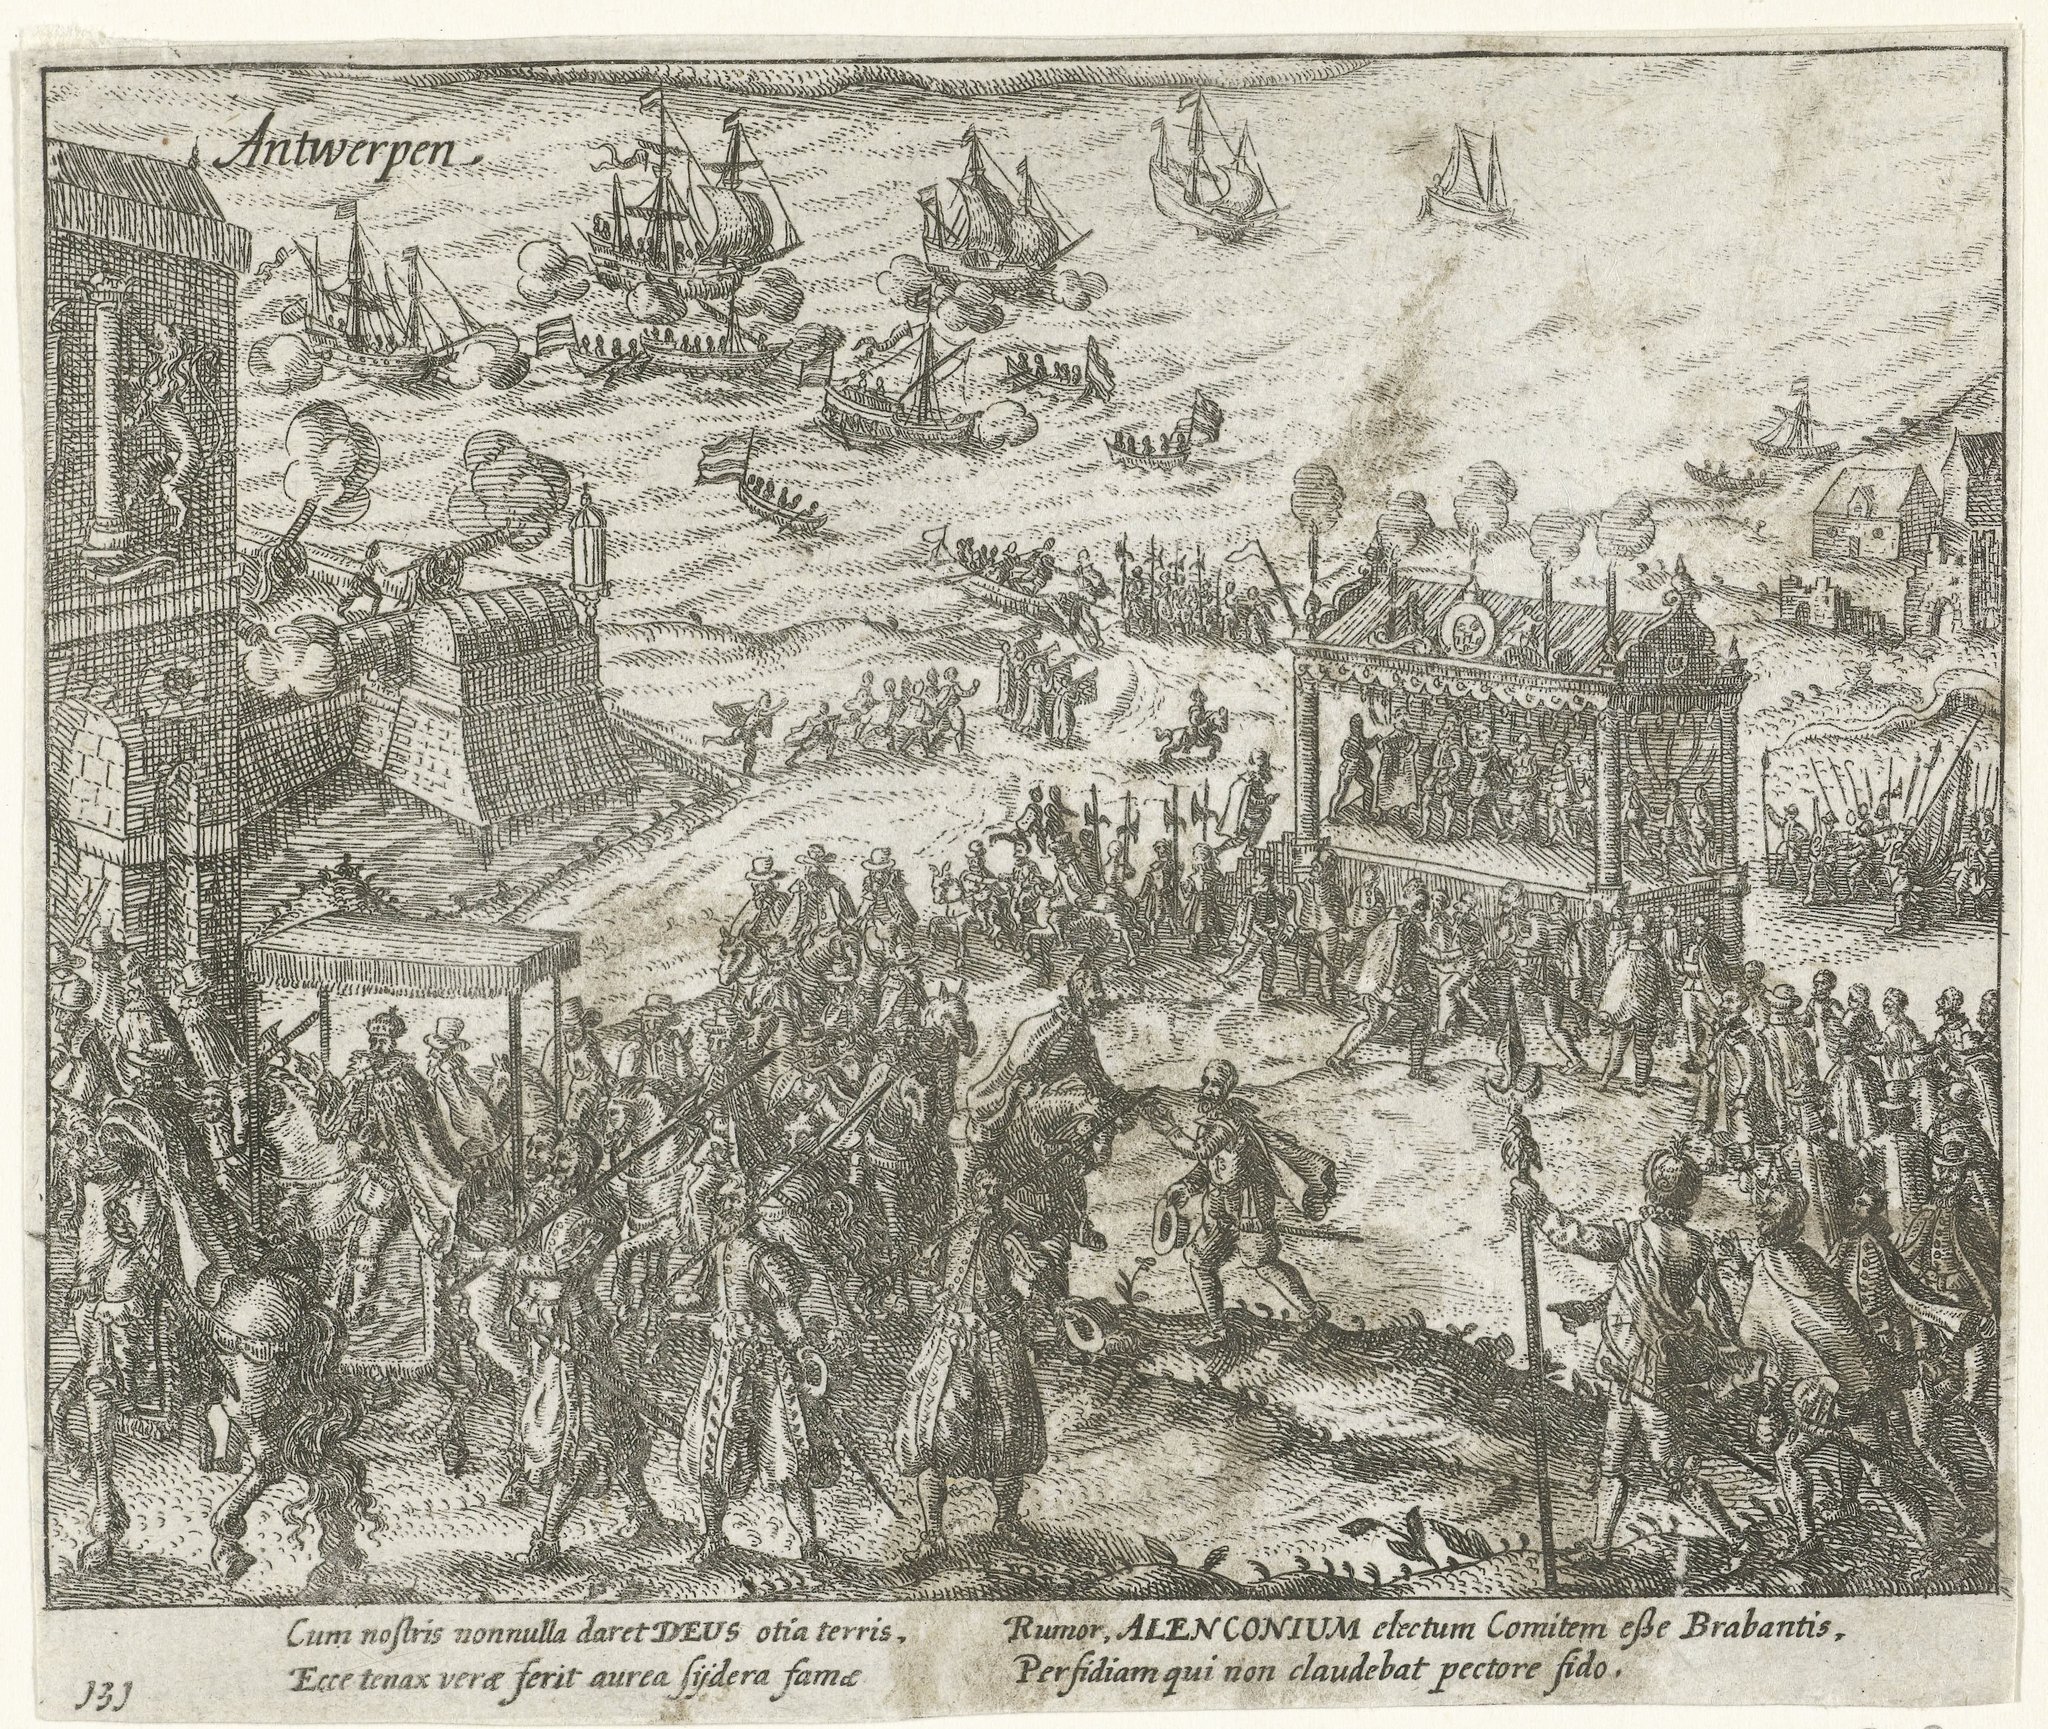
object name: history print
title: Aankomst van de hertog van Anjou te Antwerpen, 1582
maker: Anonymous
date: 1613-1615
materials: paper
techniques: etching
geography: northern netherlands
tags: delft, william i (prince of orange), françois-hercule de valois (hertog van anjou), triumphal entry and public reception, pageant, 'entrée solennelle', 'joyeuse entrée', antwerp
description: Aankomst van Anjou te Antwerpen, 19 februari 1582. Hij wordt begroet door Willem van Oranje, op een podium krijgt hij de mantel en hoed van de hertog van Brabant, op de voorgrond trekt de stoet de stad in. Met onderschrift van 4 regels in het Latijn. Genummerd 131. Bedrukt op achterzijde met tekst in het Latijn.